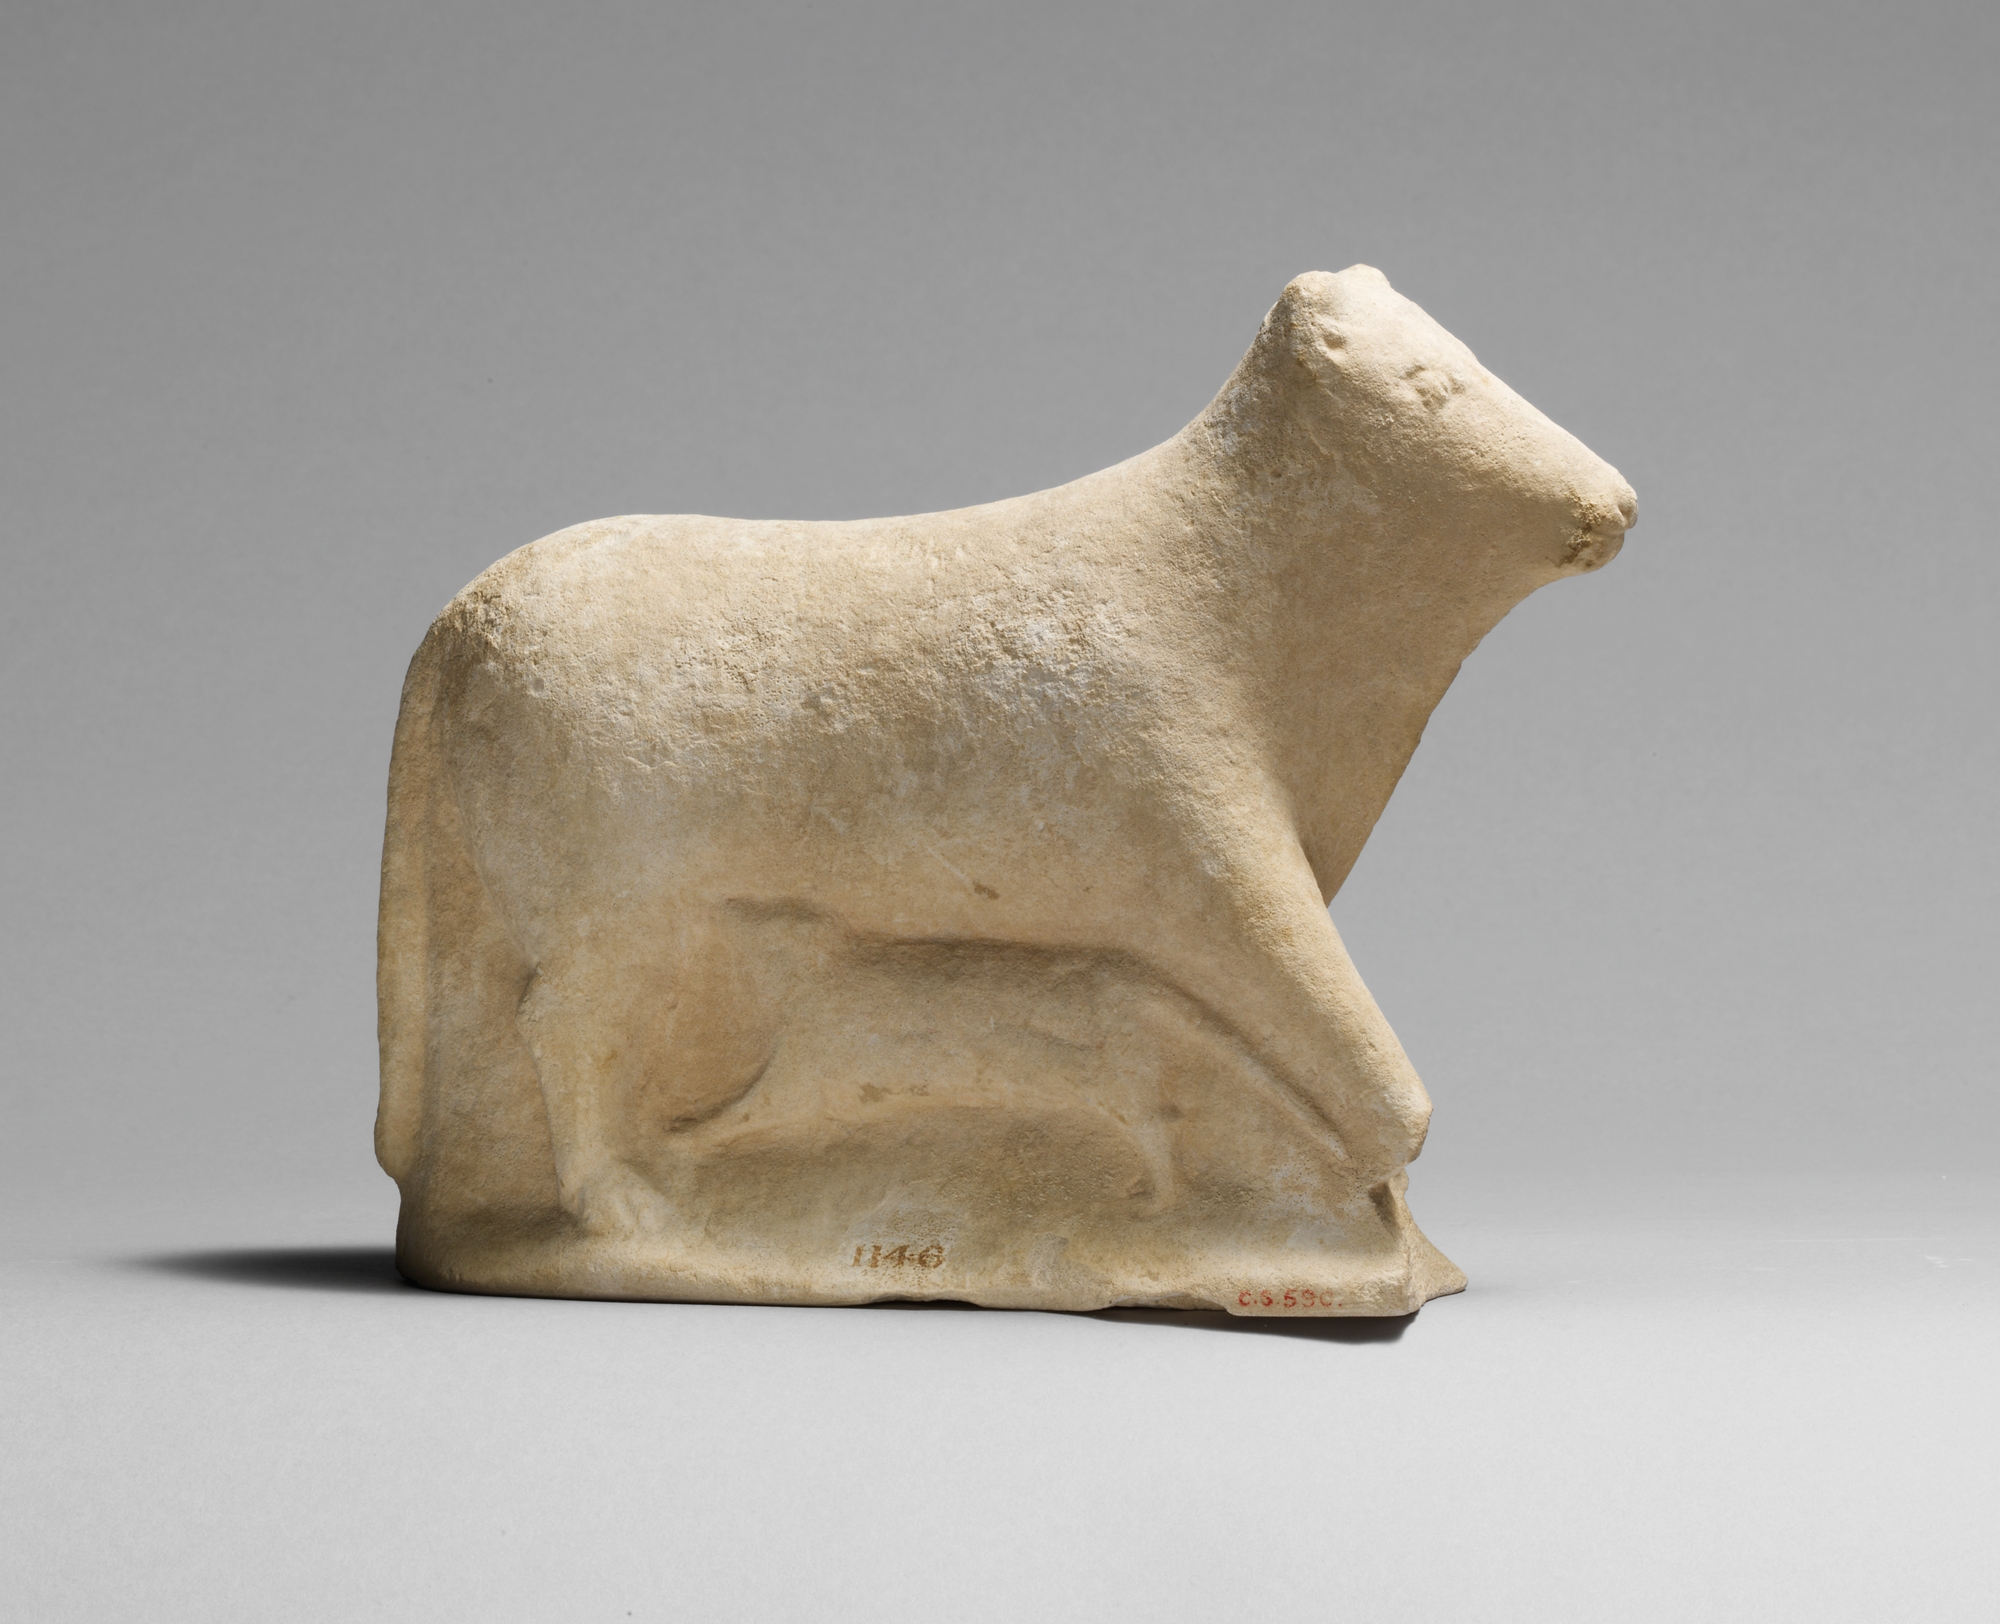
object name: statuette of a cow and calf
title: Limestone votive statuette of a cow and calf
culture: cypriot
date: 600-301 BCE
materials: limestone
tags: cows